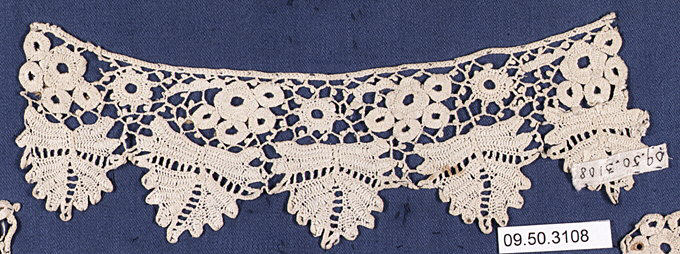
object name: fragment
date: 1801-1900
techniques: crochet